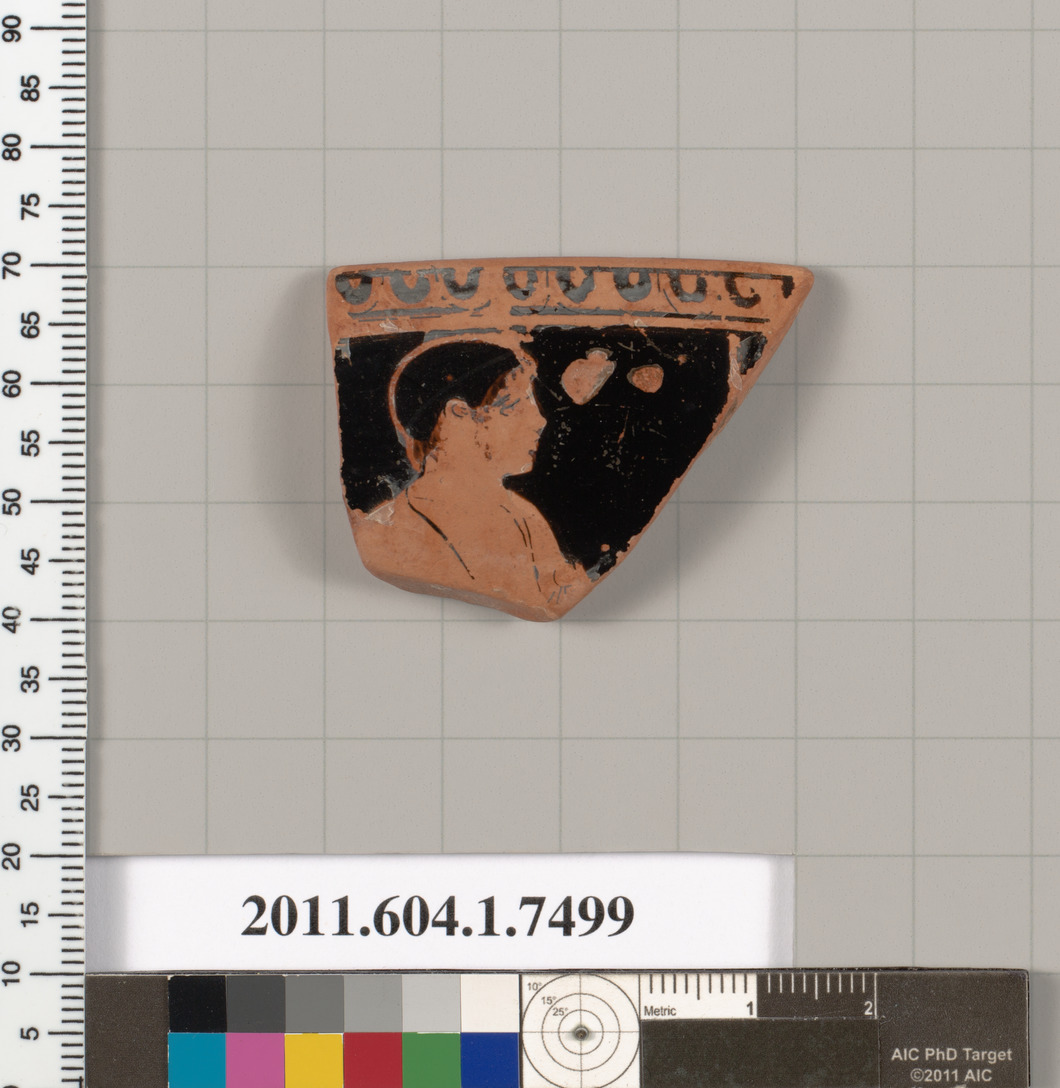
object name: kylix fragment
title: Terracotta rim fragment of a kylix (drinking cup)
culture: greek, attic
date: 460-450 BCE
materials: terracotta